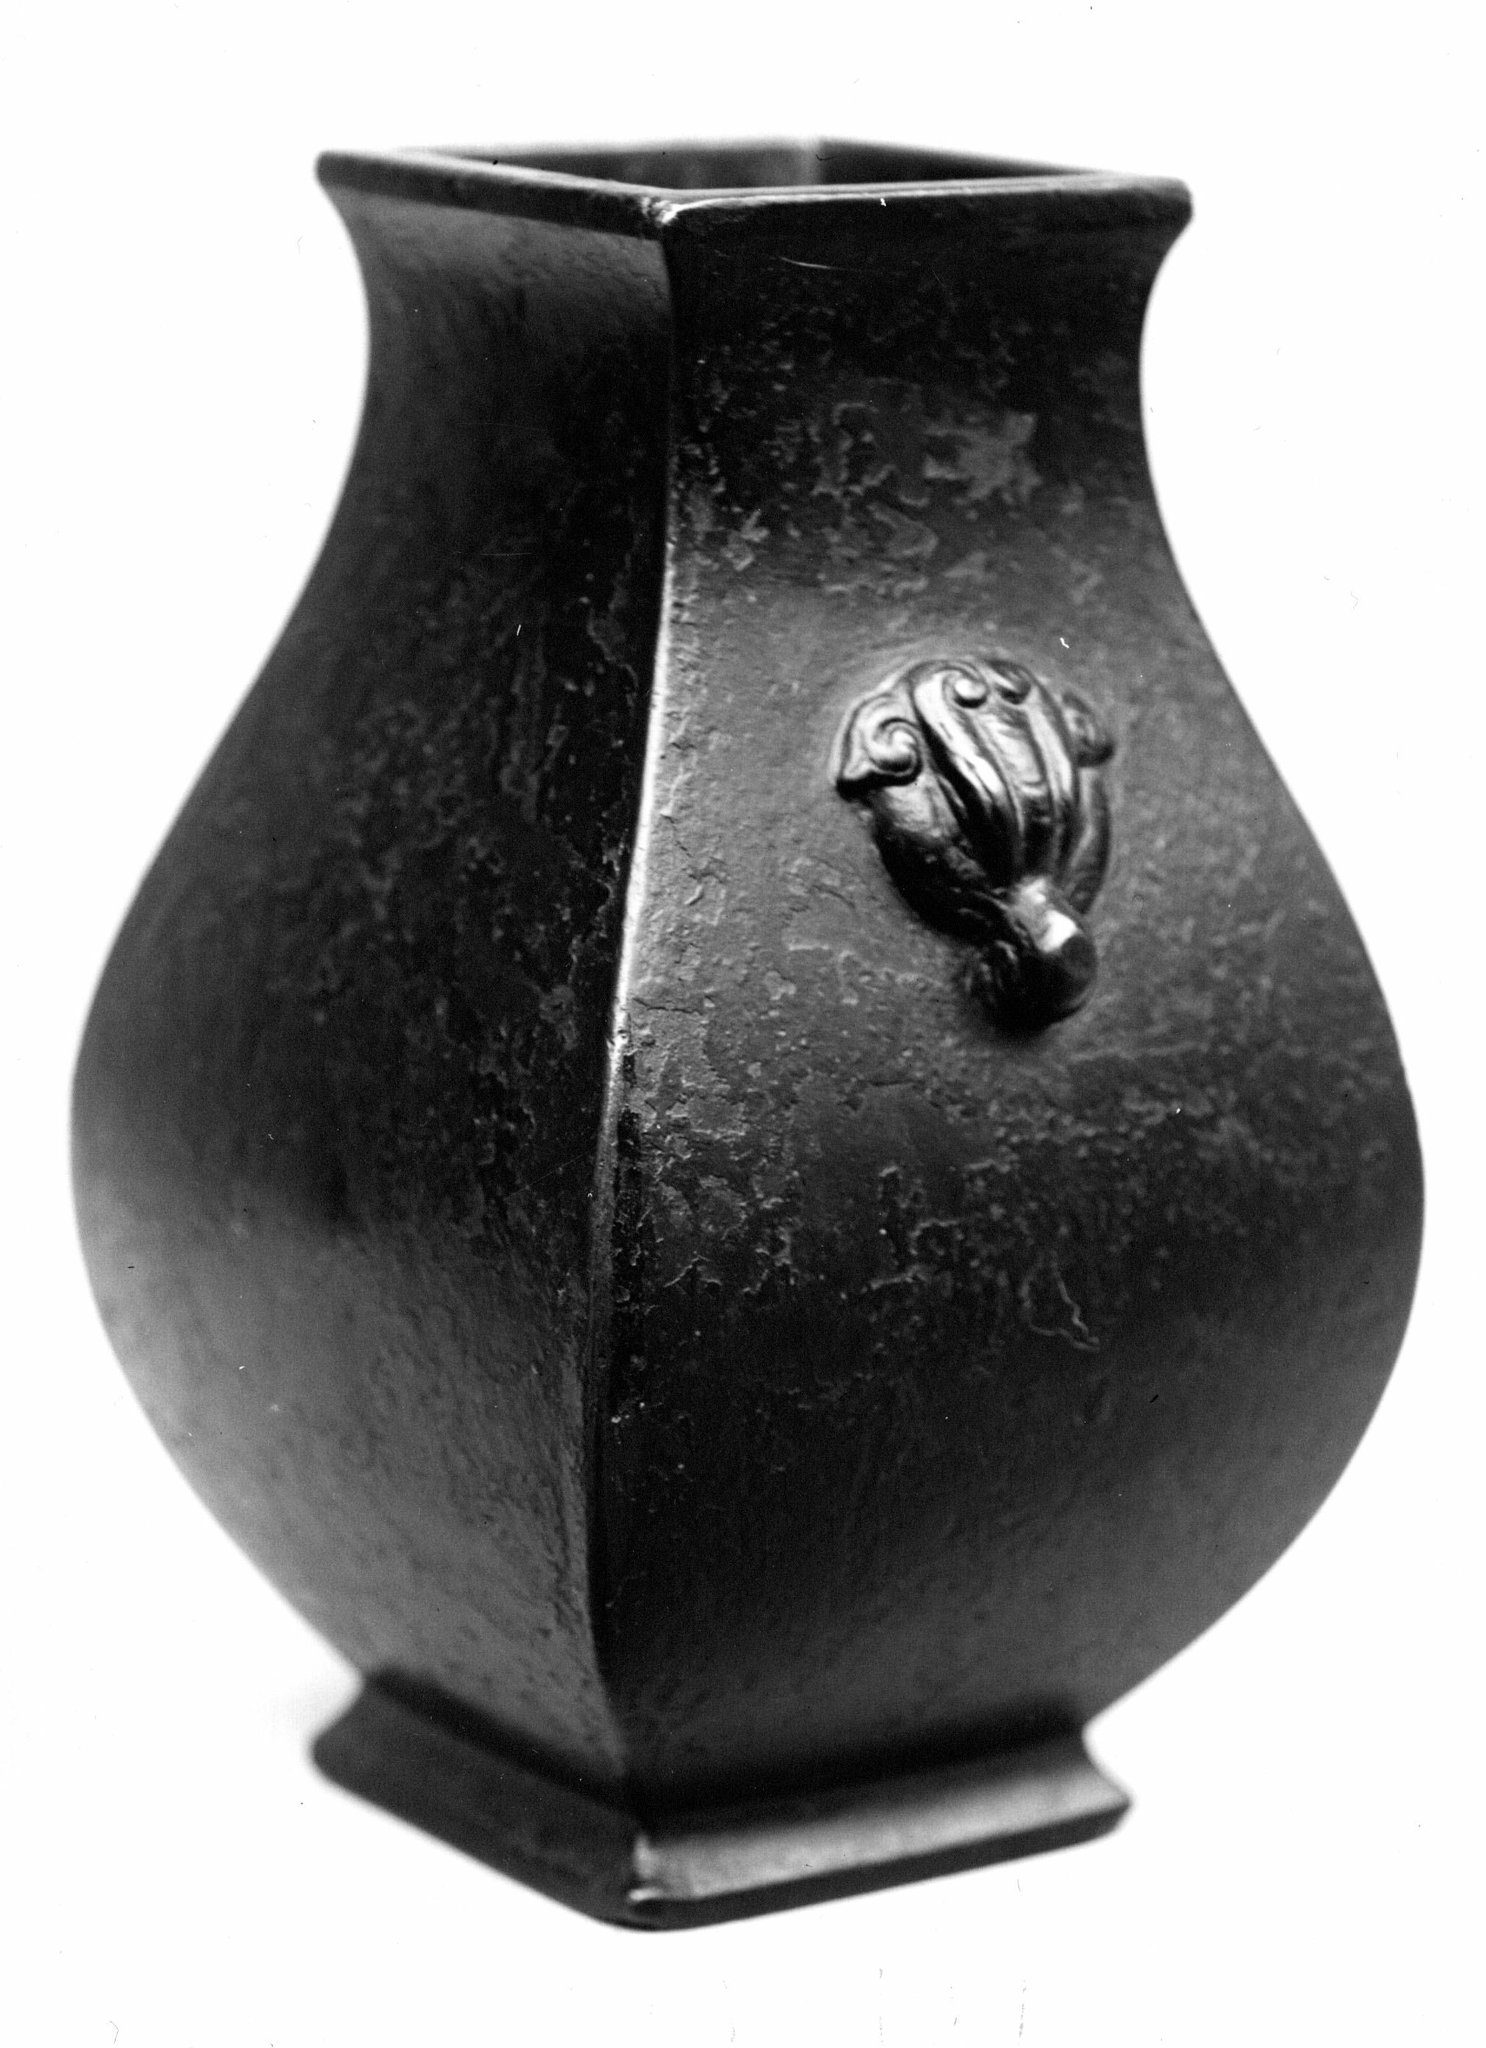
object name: vase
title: Vase (Fang)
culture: chinese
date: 1701-1900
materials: bronze